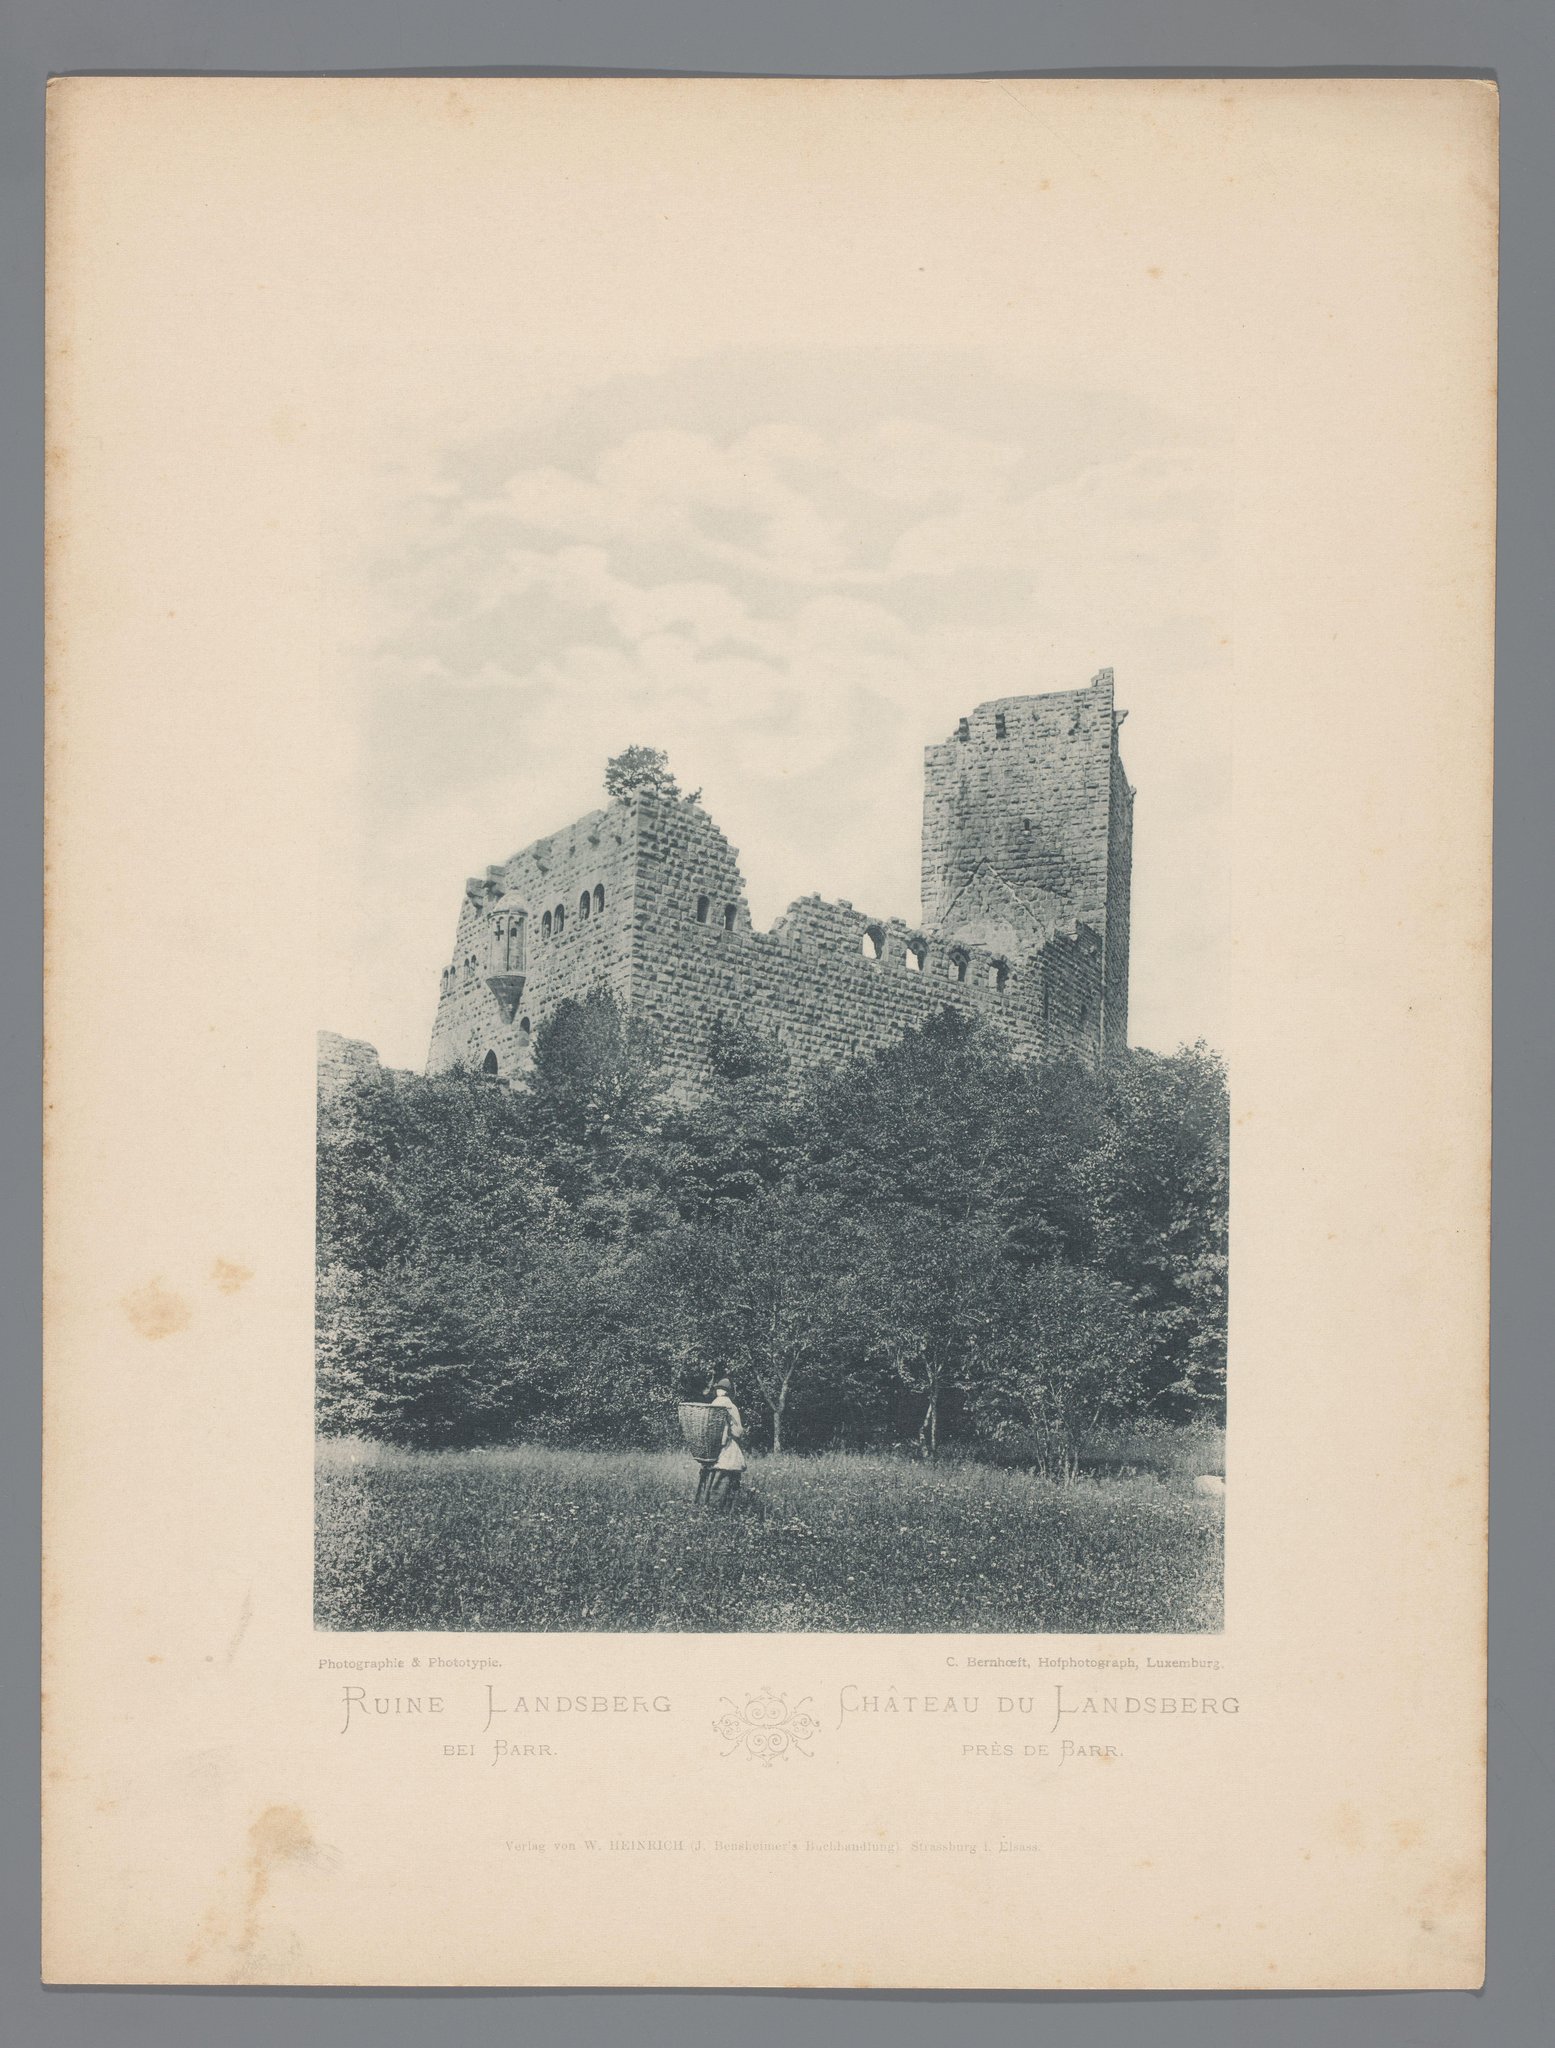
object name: page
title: Ruine Landsberg, Château du Landsberg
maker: charles bernhoeft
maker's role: publisher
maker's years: 1859-1933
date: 1889-1894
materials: paper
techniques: photograph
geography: straatsburg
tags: castle, landscape with ruins (+ city(-scape) with figures, staffage)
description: Deze prent maakt deel uit van een omslag met 100 prenten.